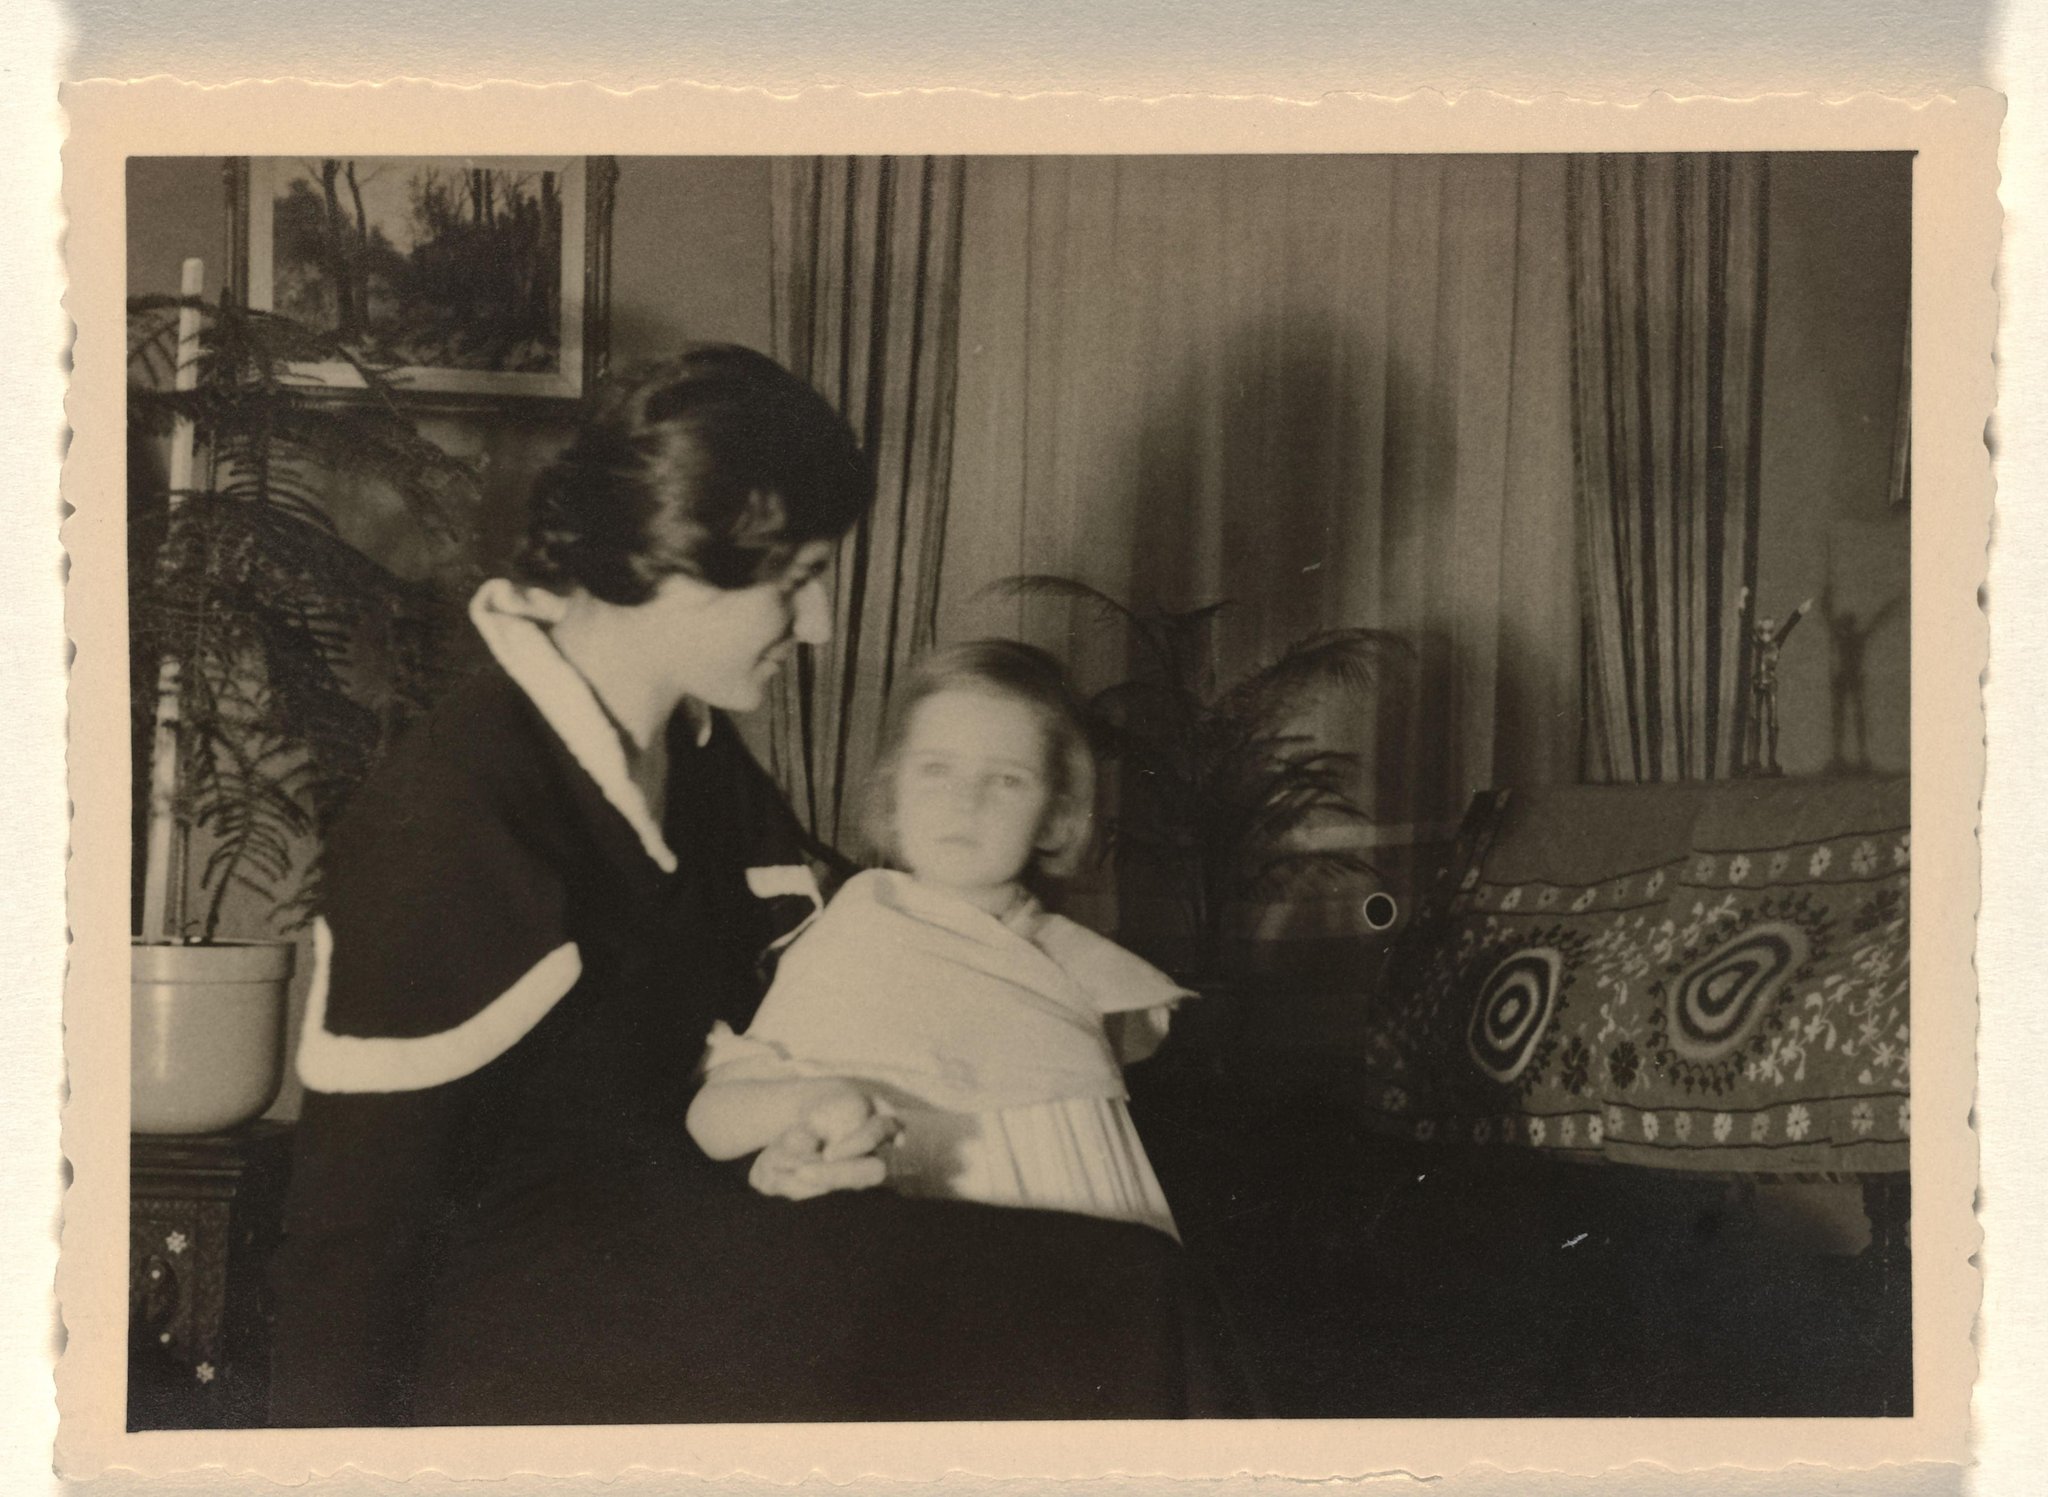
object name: photograph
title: Isabel Wachenheimer tijdens Kerst 1932 in Stuttgart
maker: Anonymous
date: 1912-1932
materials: photographic support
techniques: gelatin silver print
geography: stuttgart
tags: leiden, isabel wachenheimer-elon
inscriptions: date: ‘Weihn.32.’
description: Dit object is onderdeel van de nalatenschap van Isabel Elon-Wachenheimer (1928-2010). Tot haar overlijden behoorde het samen met de andere objecten uit de nalatenschap tot haar privédomein van Isabel Wachenheimer. In die particuliere context zijn deze objecten tezamen en individueel aandenkens - aan de jeugd, ouders en familie van Isabel Wachenheimer vóór en tijdens de Shoah en aan haar leven na de Tweede Wereldoorlog. Isabel Wachenheimer, die van juni 1943 tot mei 1945 gevangen zat in Kamp Westerbork, Theresienstadt, Auschwitz, Lenzing a/d Oberdonau (een buitenkamp van Mauthausen), overleefde de Shoah. Haar ouders – Eugène Wachenheimer en Else Wachenheimer-Moos - werden op 14 oktober 1944 in Auschwitz-Birkenau vermoord.